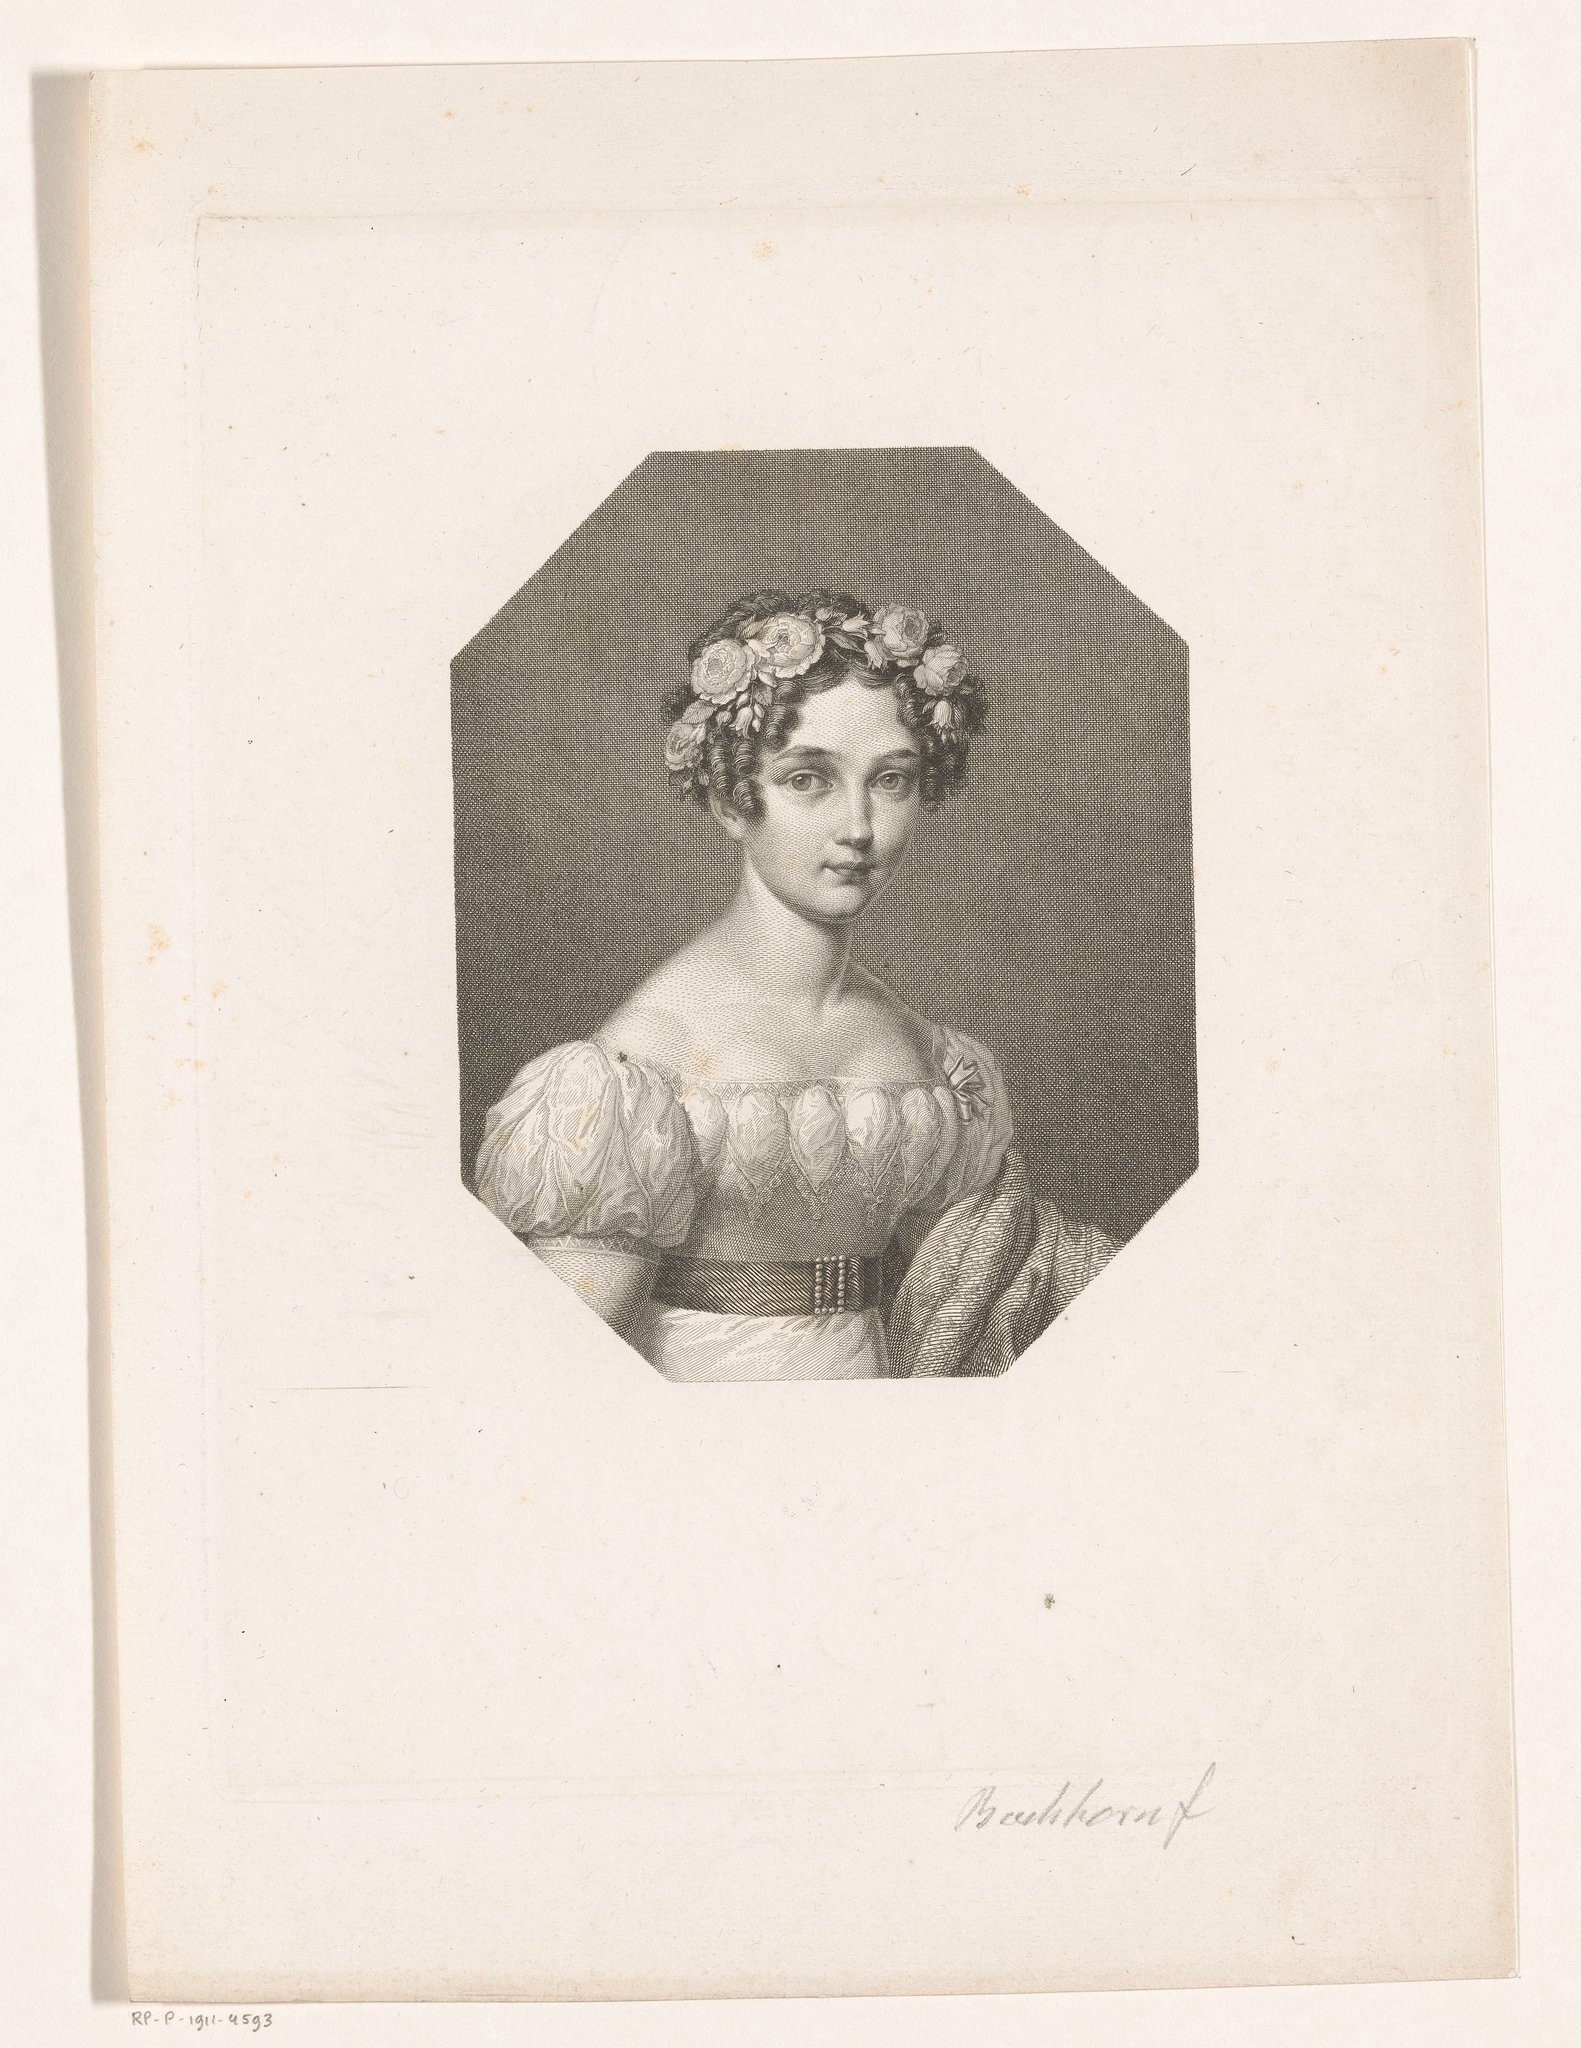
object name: print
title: Portret van Elisabeth Ludovika van Beieren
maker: ludwig buchhorn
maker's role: painter, print maker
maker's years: 1770-1856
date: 1811-1856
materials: paper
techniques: engraving, etching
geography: berlin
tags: historical persons - bb - woman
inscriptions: collector's mark: Lugt 2228